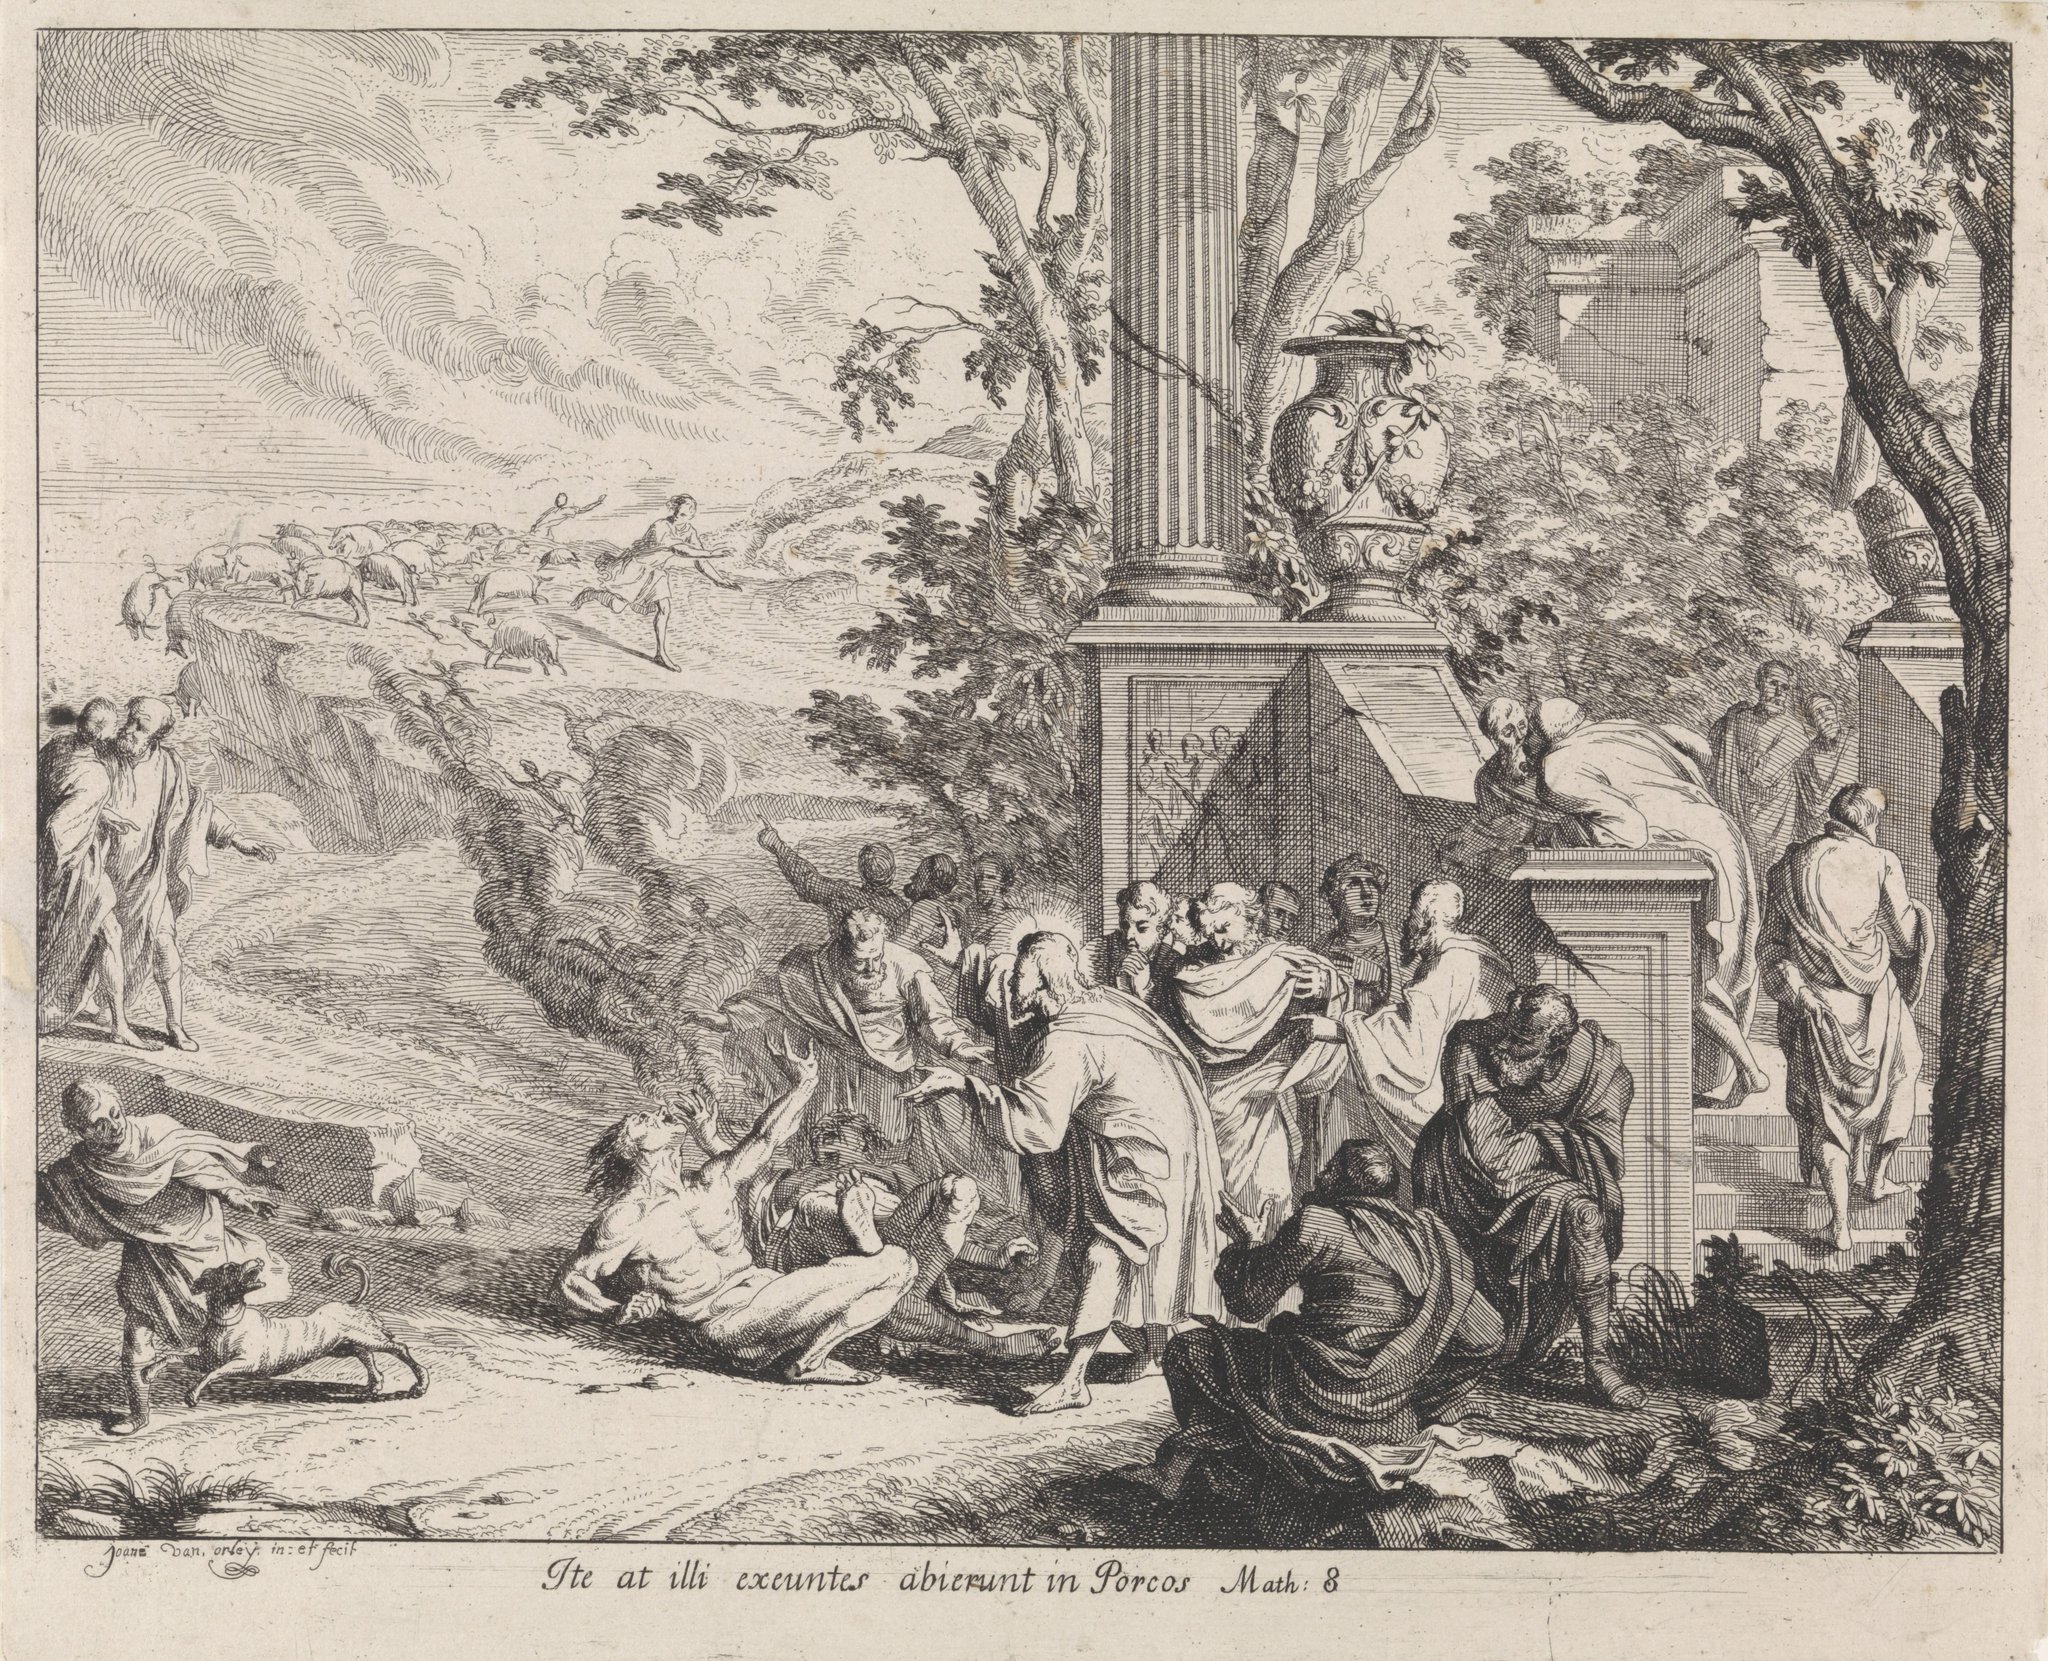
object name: print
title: Scènes uit het Nieuwe Testament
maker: jan van orley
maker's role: print maker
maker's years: 1665-1735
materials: paper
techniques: engraving, etching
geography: brussels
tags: the demons enter into a herd of swine, which leap into the sea ~ healing of two possessed at gerasa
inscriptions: collector's mark: Lugt 240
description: Christus geneest twee bezetenen en stuurt hun demonen naar een varkenskudde. De bezetenen liggen voor hem op de grond. In een rookwolk zijn de demonen herkenbaar. De kudde met varkens rent wild door elkaar heen. Een deel van de varkens valt vanaf een rots in zee. Onder de afbeelding een Latijns vers uit Mat. 8.